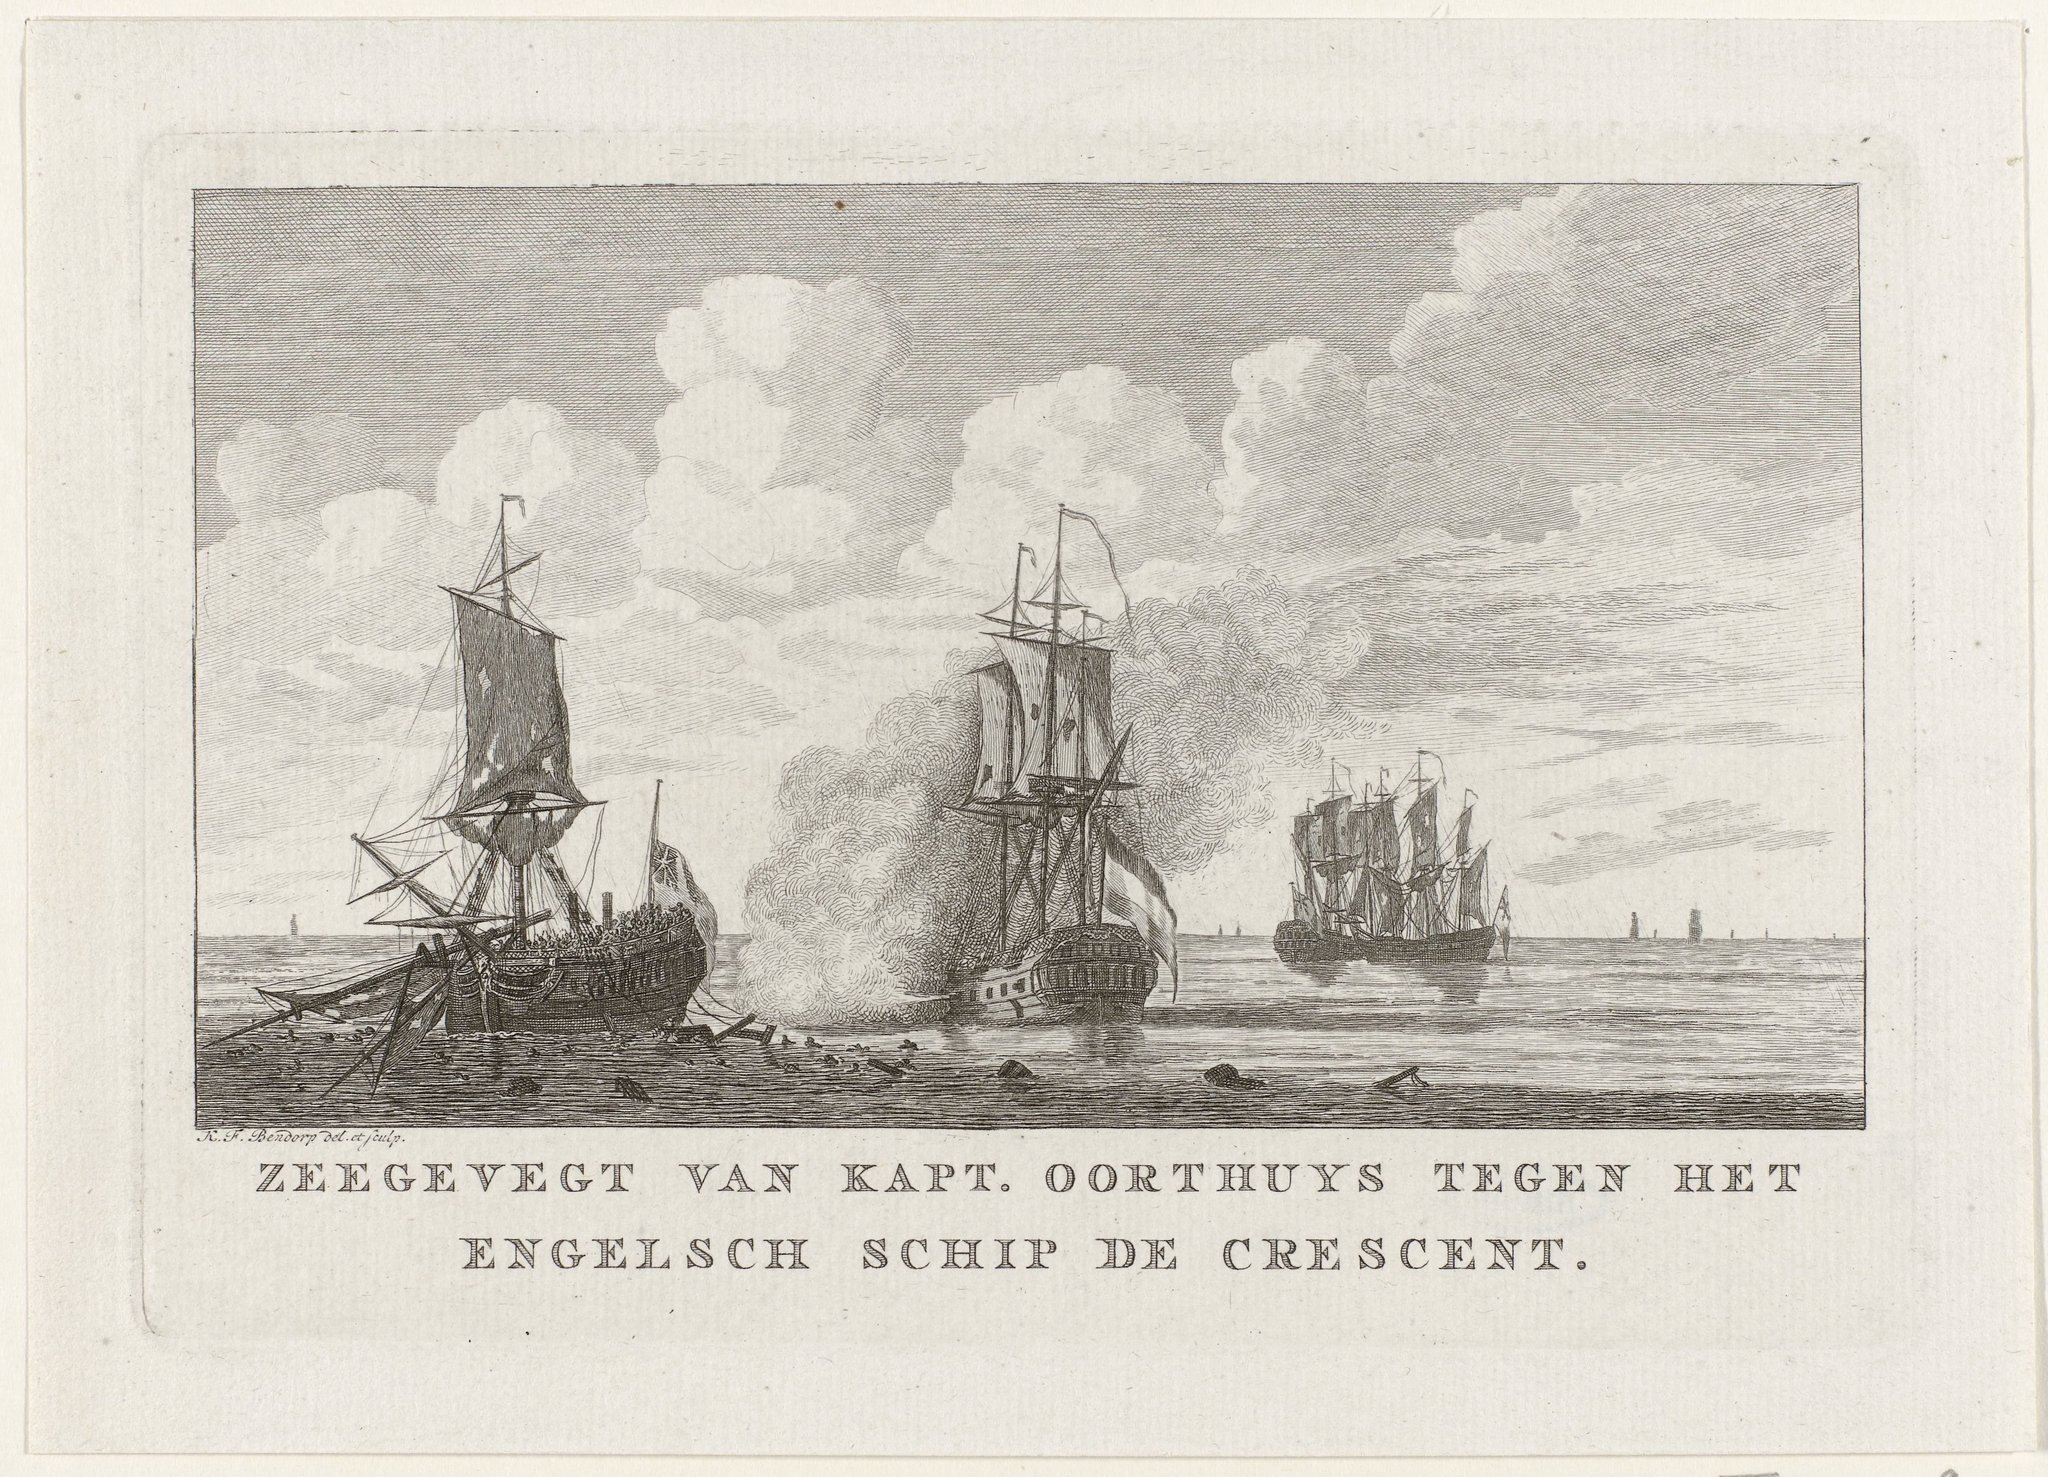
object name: print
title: Zeeslag bij Cadiz, 1781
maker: carel frederik bendorp (i)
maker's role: print maker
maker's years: 1736-1814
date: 1781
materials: paper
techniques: engraving, etching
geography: northern netherlands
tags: dordrecht, naval officer, pieter melvill van carnbee, rotterdam, gerardus oorthuys, battle (+ naval force)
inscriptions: collector's mark: Lugt 2228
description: Zeegevecht bij Cadiz tussen twee Nederlandse fregatten Castor en Den Briel en twee Engelse fregatten Flora en Crescent, 30 mei 1781. Het Engelse schip Crescent reddeloos geschoten door het Nederandse fregat Briel onder bevel van Gerardus Oosthuys, op de achtergrond de twee andere schepen.